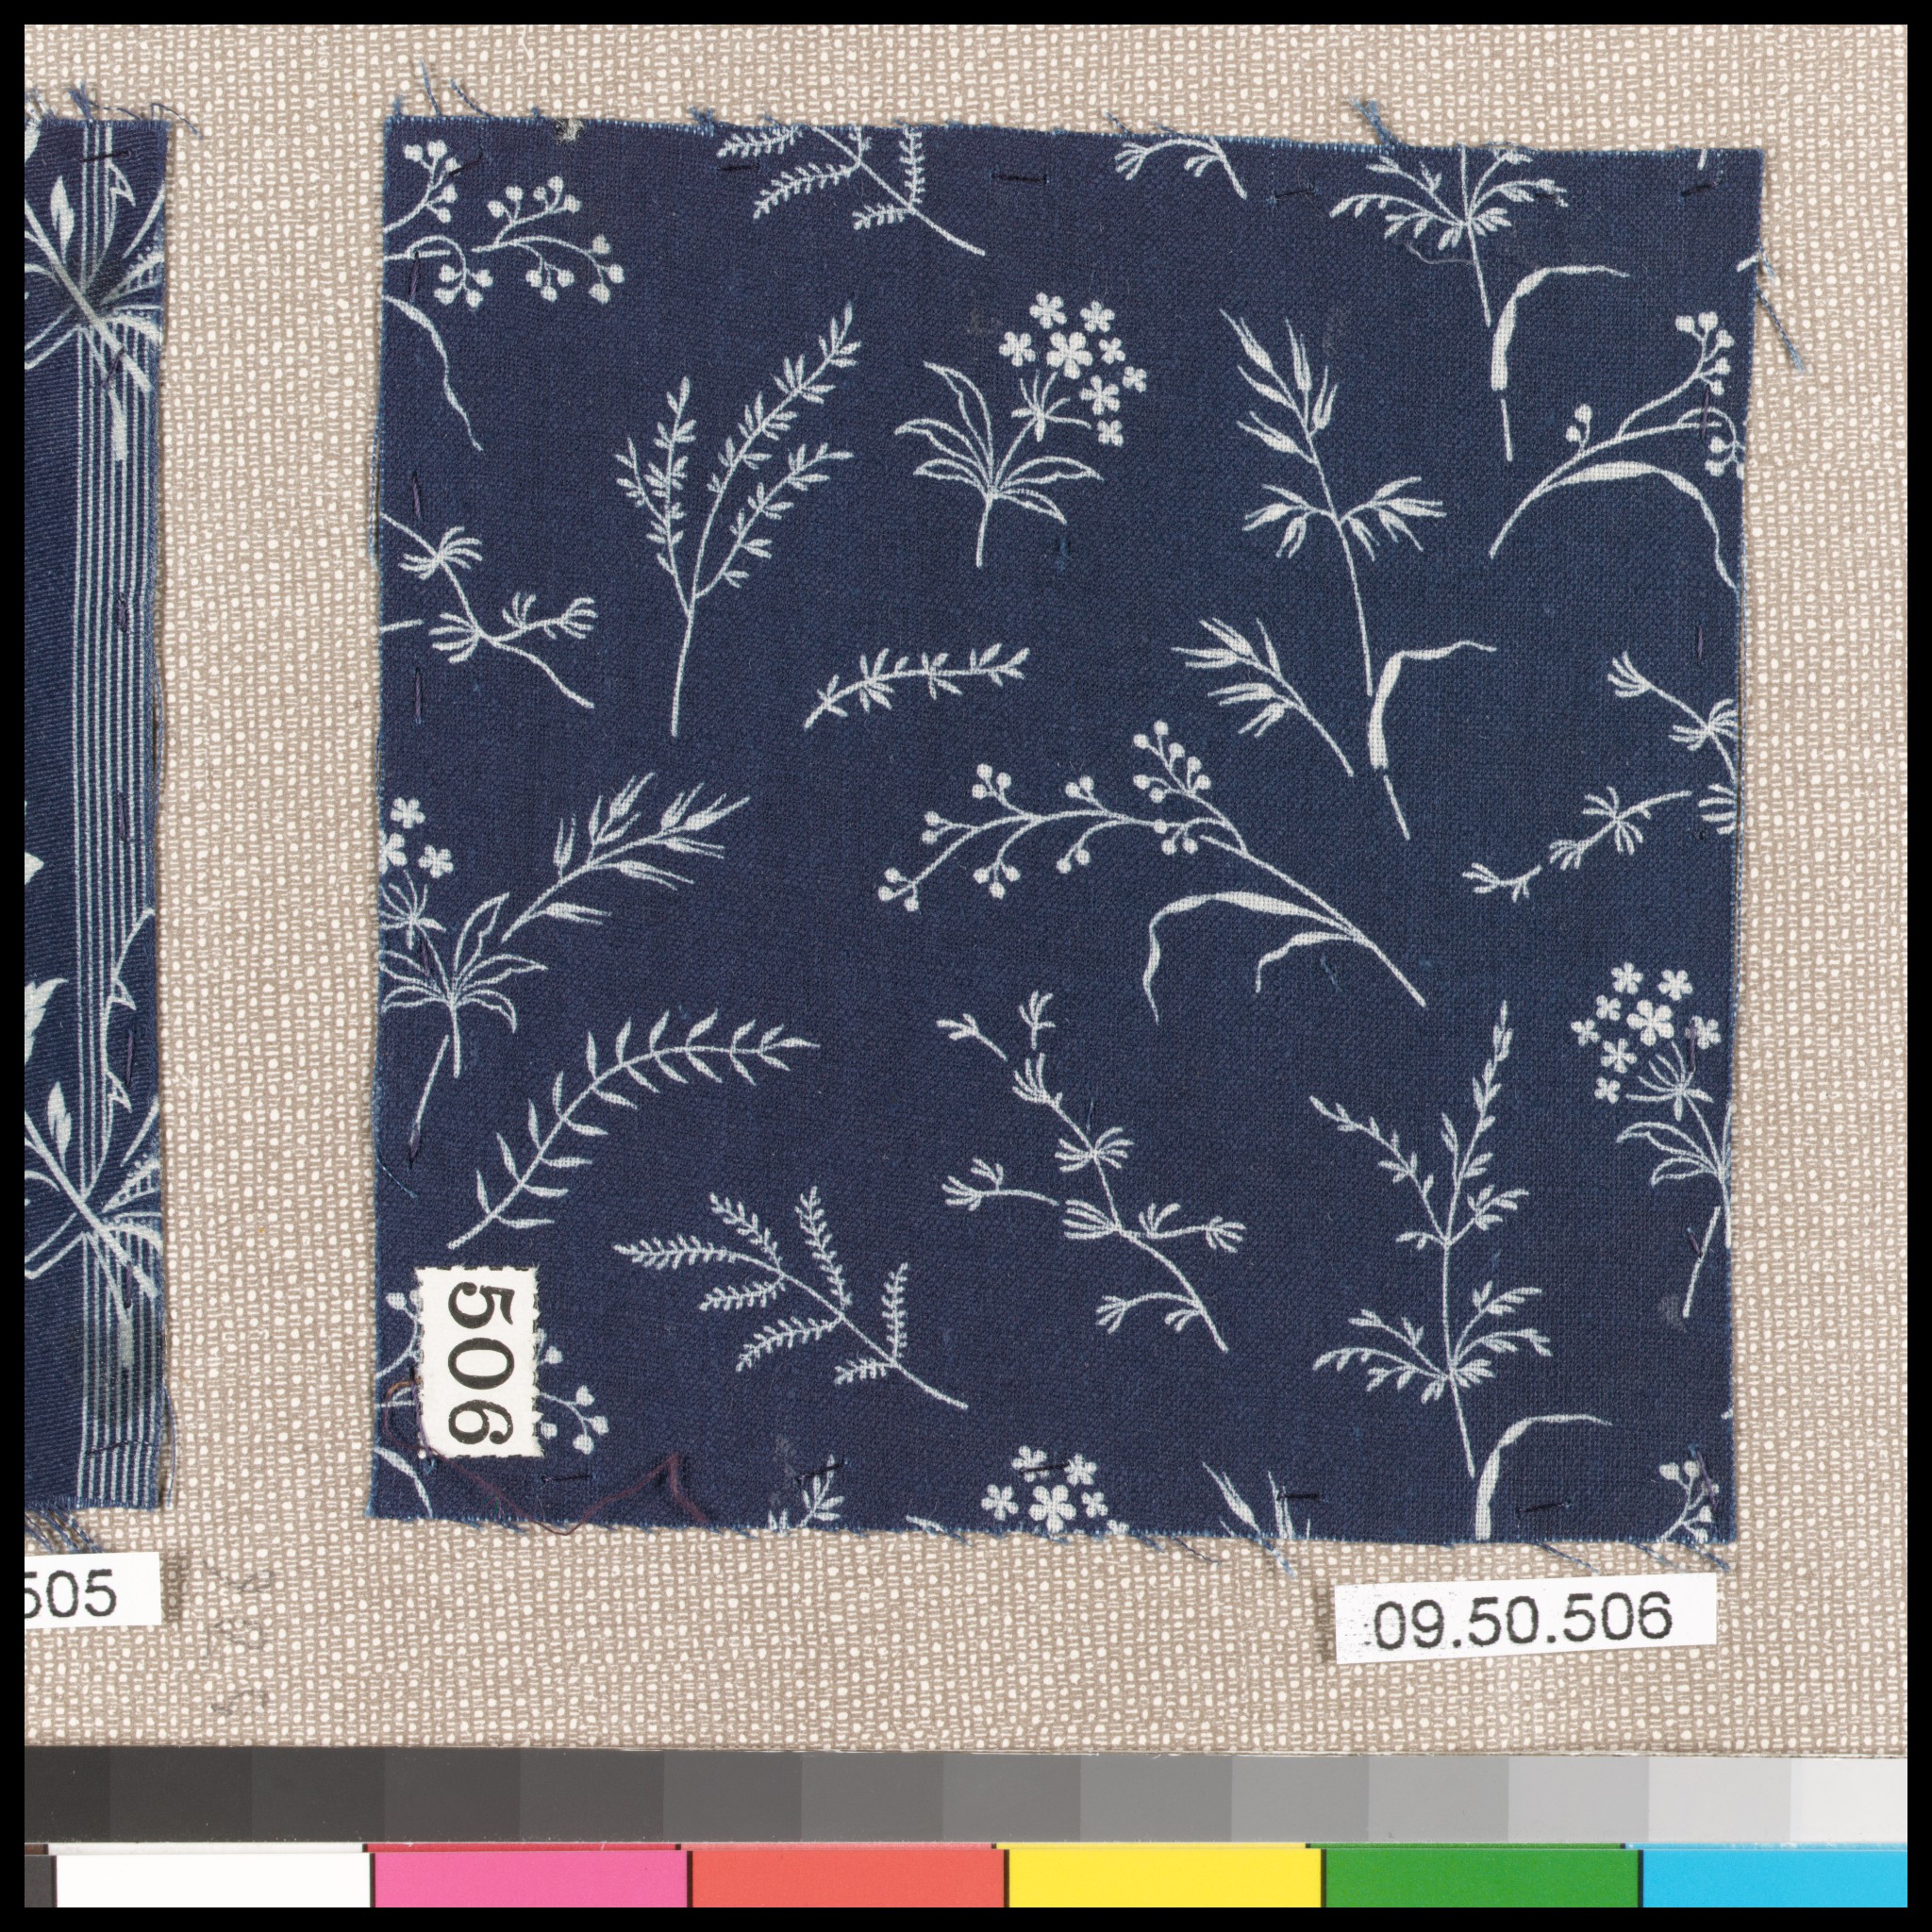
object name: piece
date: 1801-1900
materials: cotton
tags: flowers,leaves